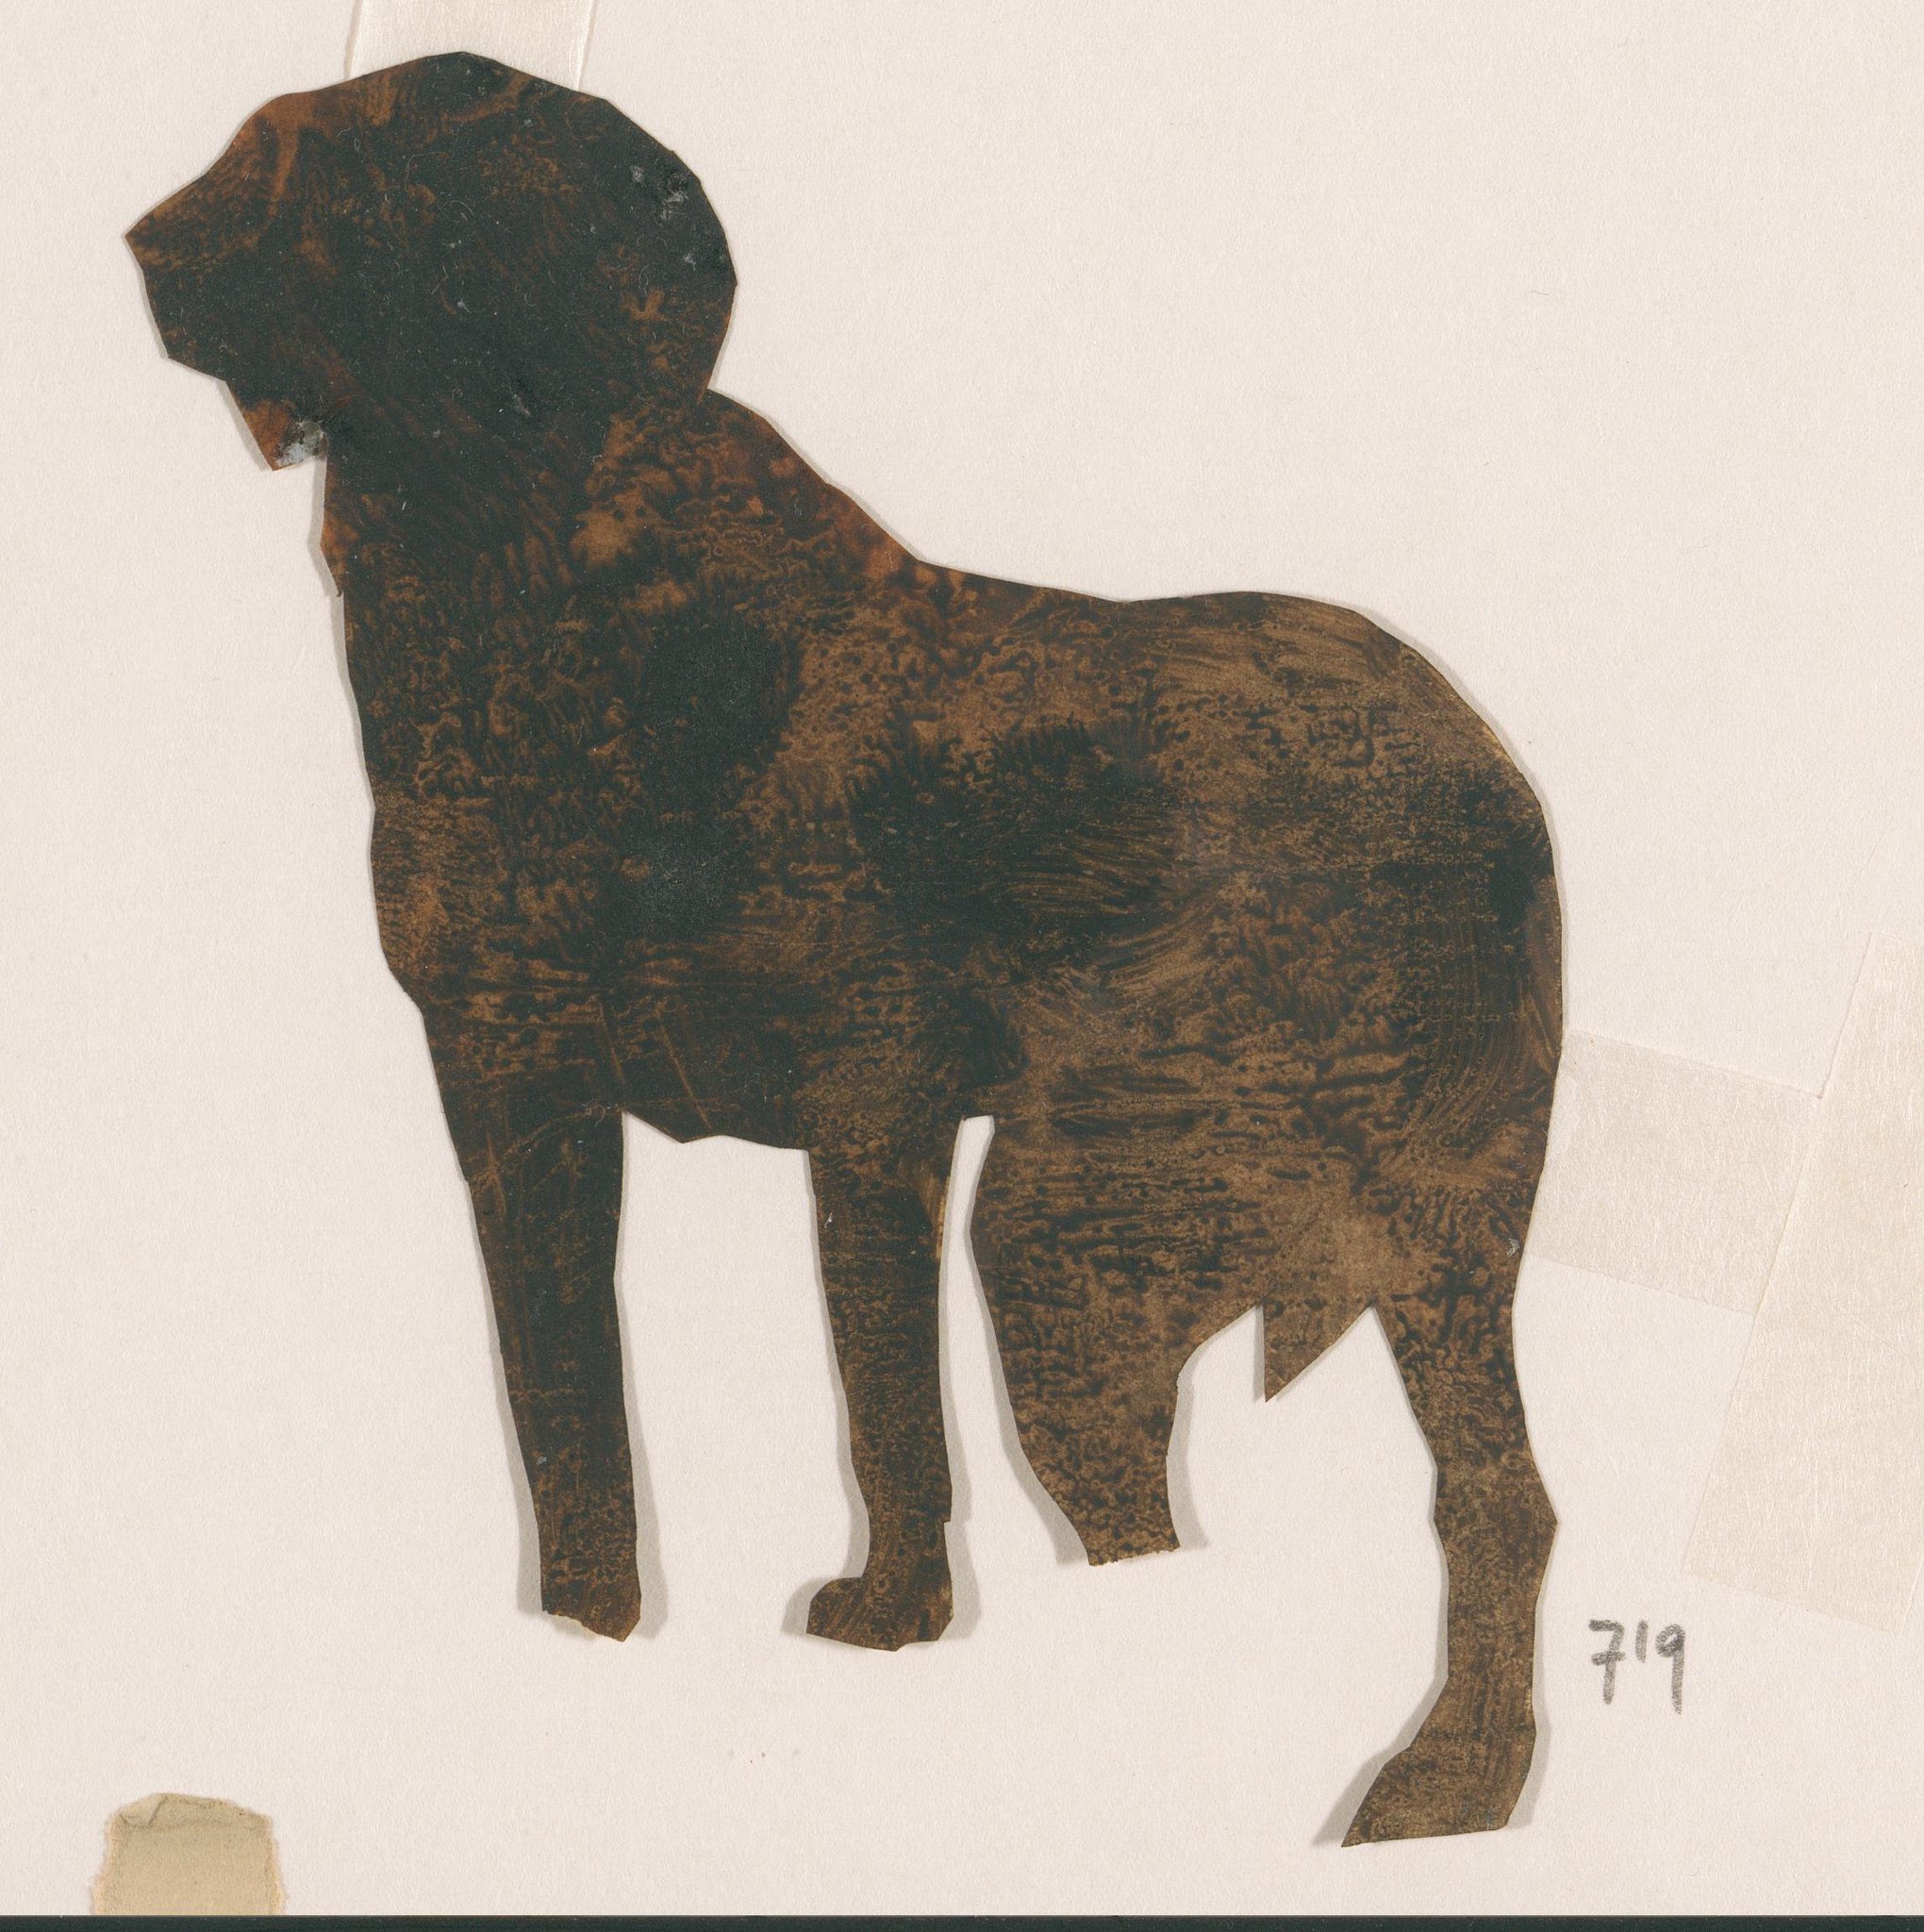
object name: clipping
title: Hond (uitgeknipt)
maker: johannes tavenraat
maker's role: draughtsman, painter, print maker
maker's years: 1809-1881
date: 1840-1880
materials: paint, paper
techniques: brush, snipping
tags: hunting dogs, dog